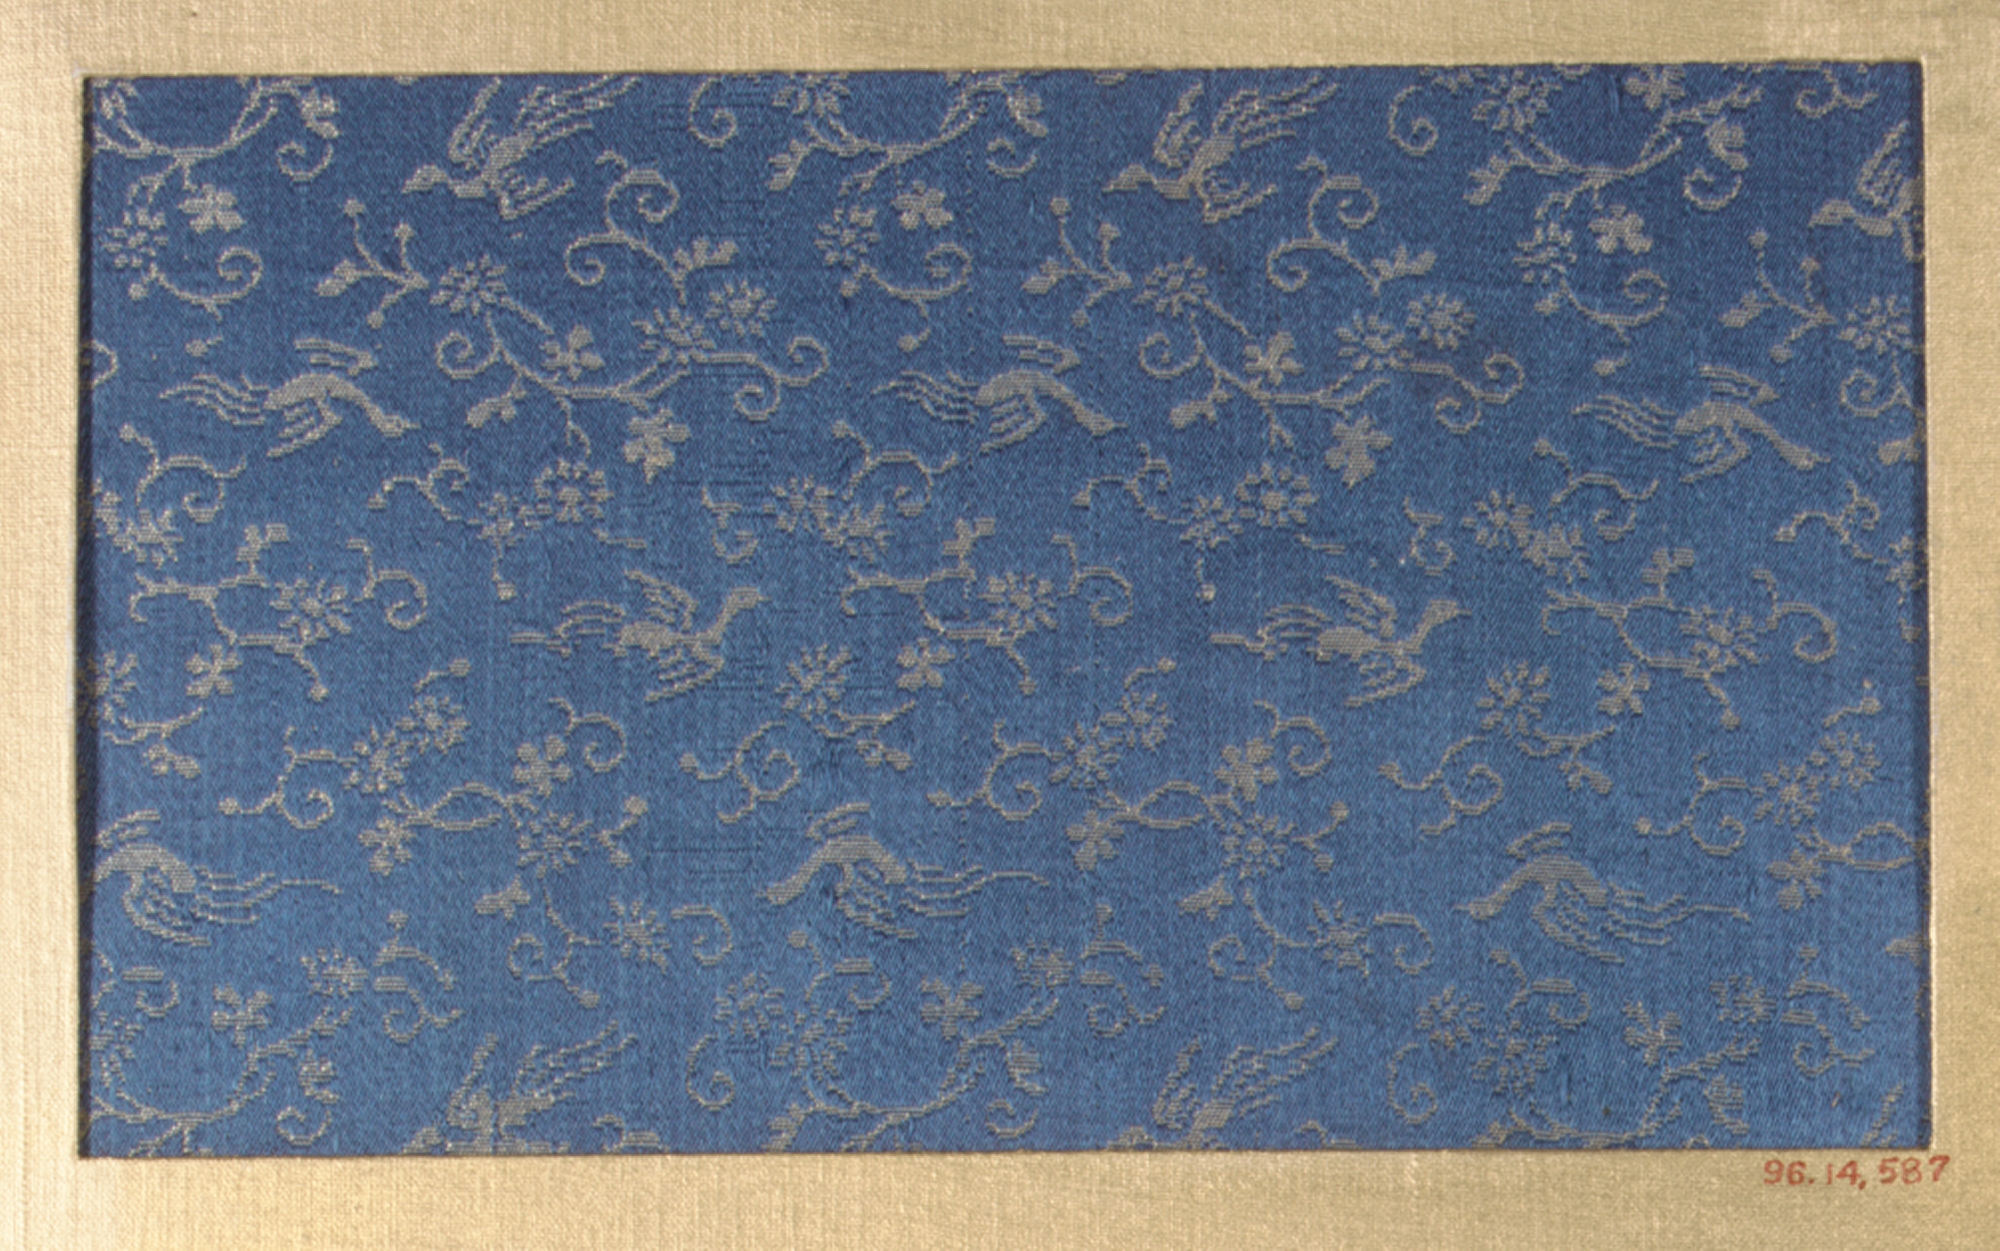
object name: piece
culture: japanese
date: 1701-1900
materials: silk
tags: flowers